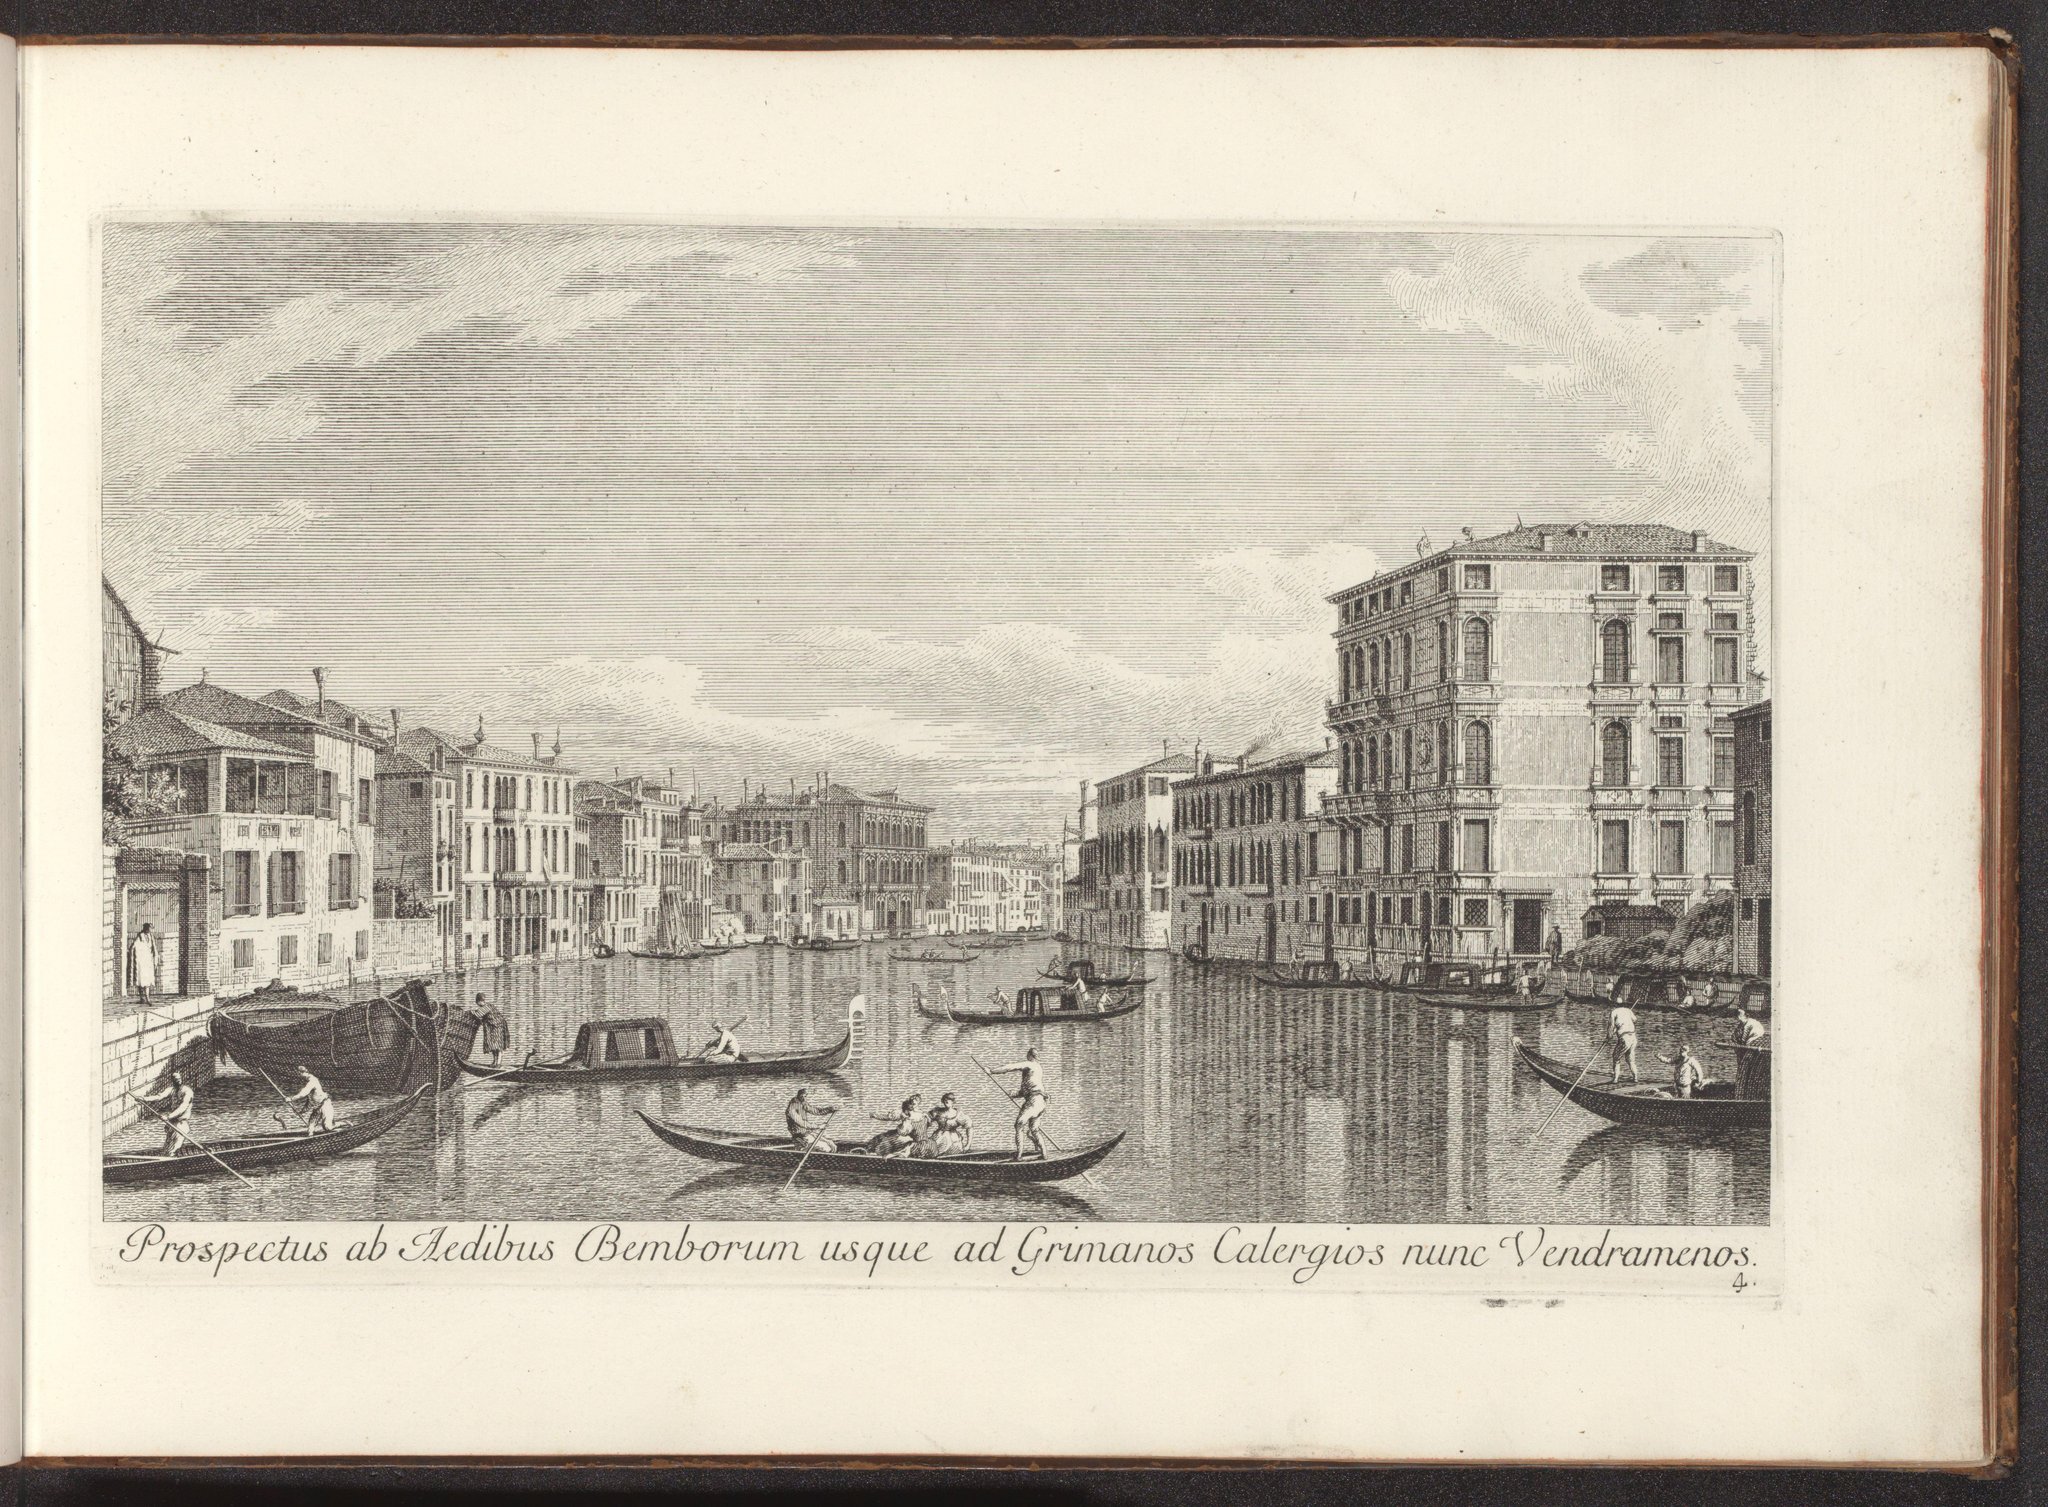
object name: album leaf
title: Prospectus ad Aedibus Bemborum usque ad Grimanos Calergios nunc Vendramenos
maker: antonio visentini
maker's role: draughtsman, print maker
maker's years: 1688-1782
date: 1742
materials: paper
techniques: etching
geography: venice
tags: city-view, and landscape with man-made constructions, canal